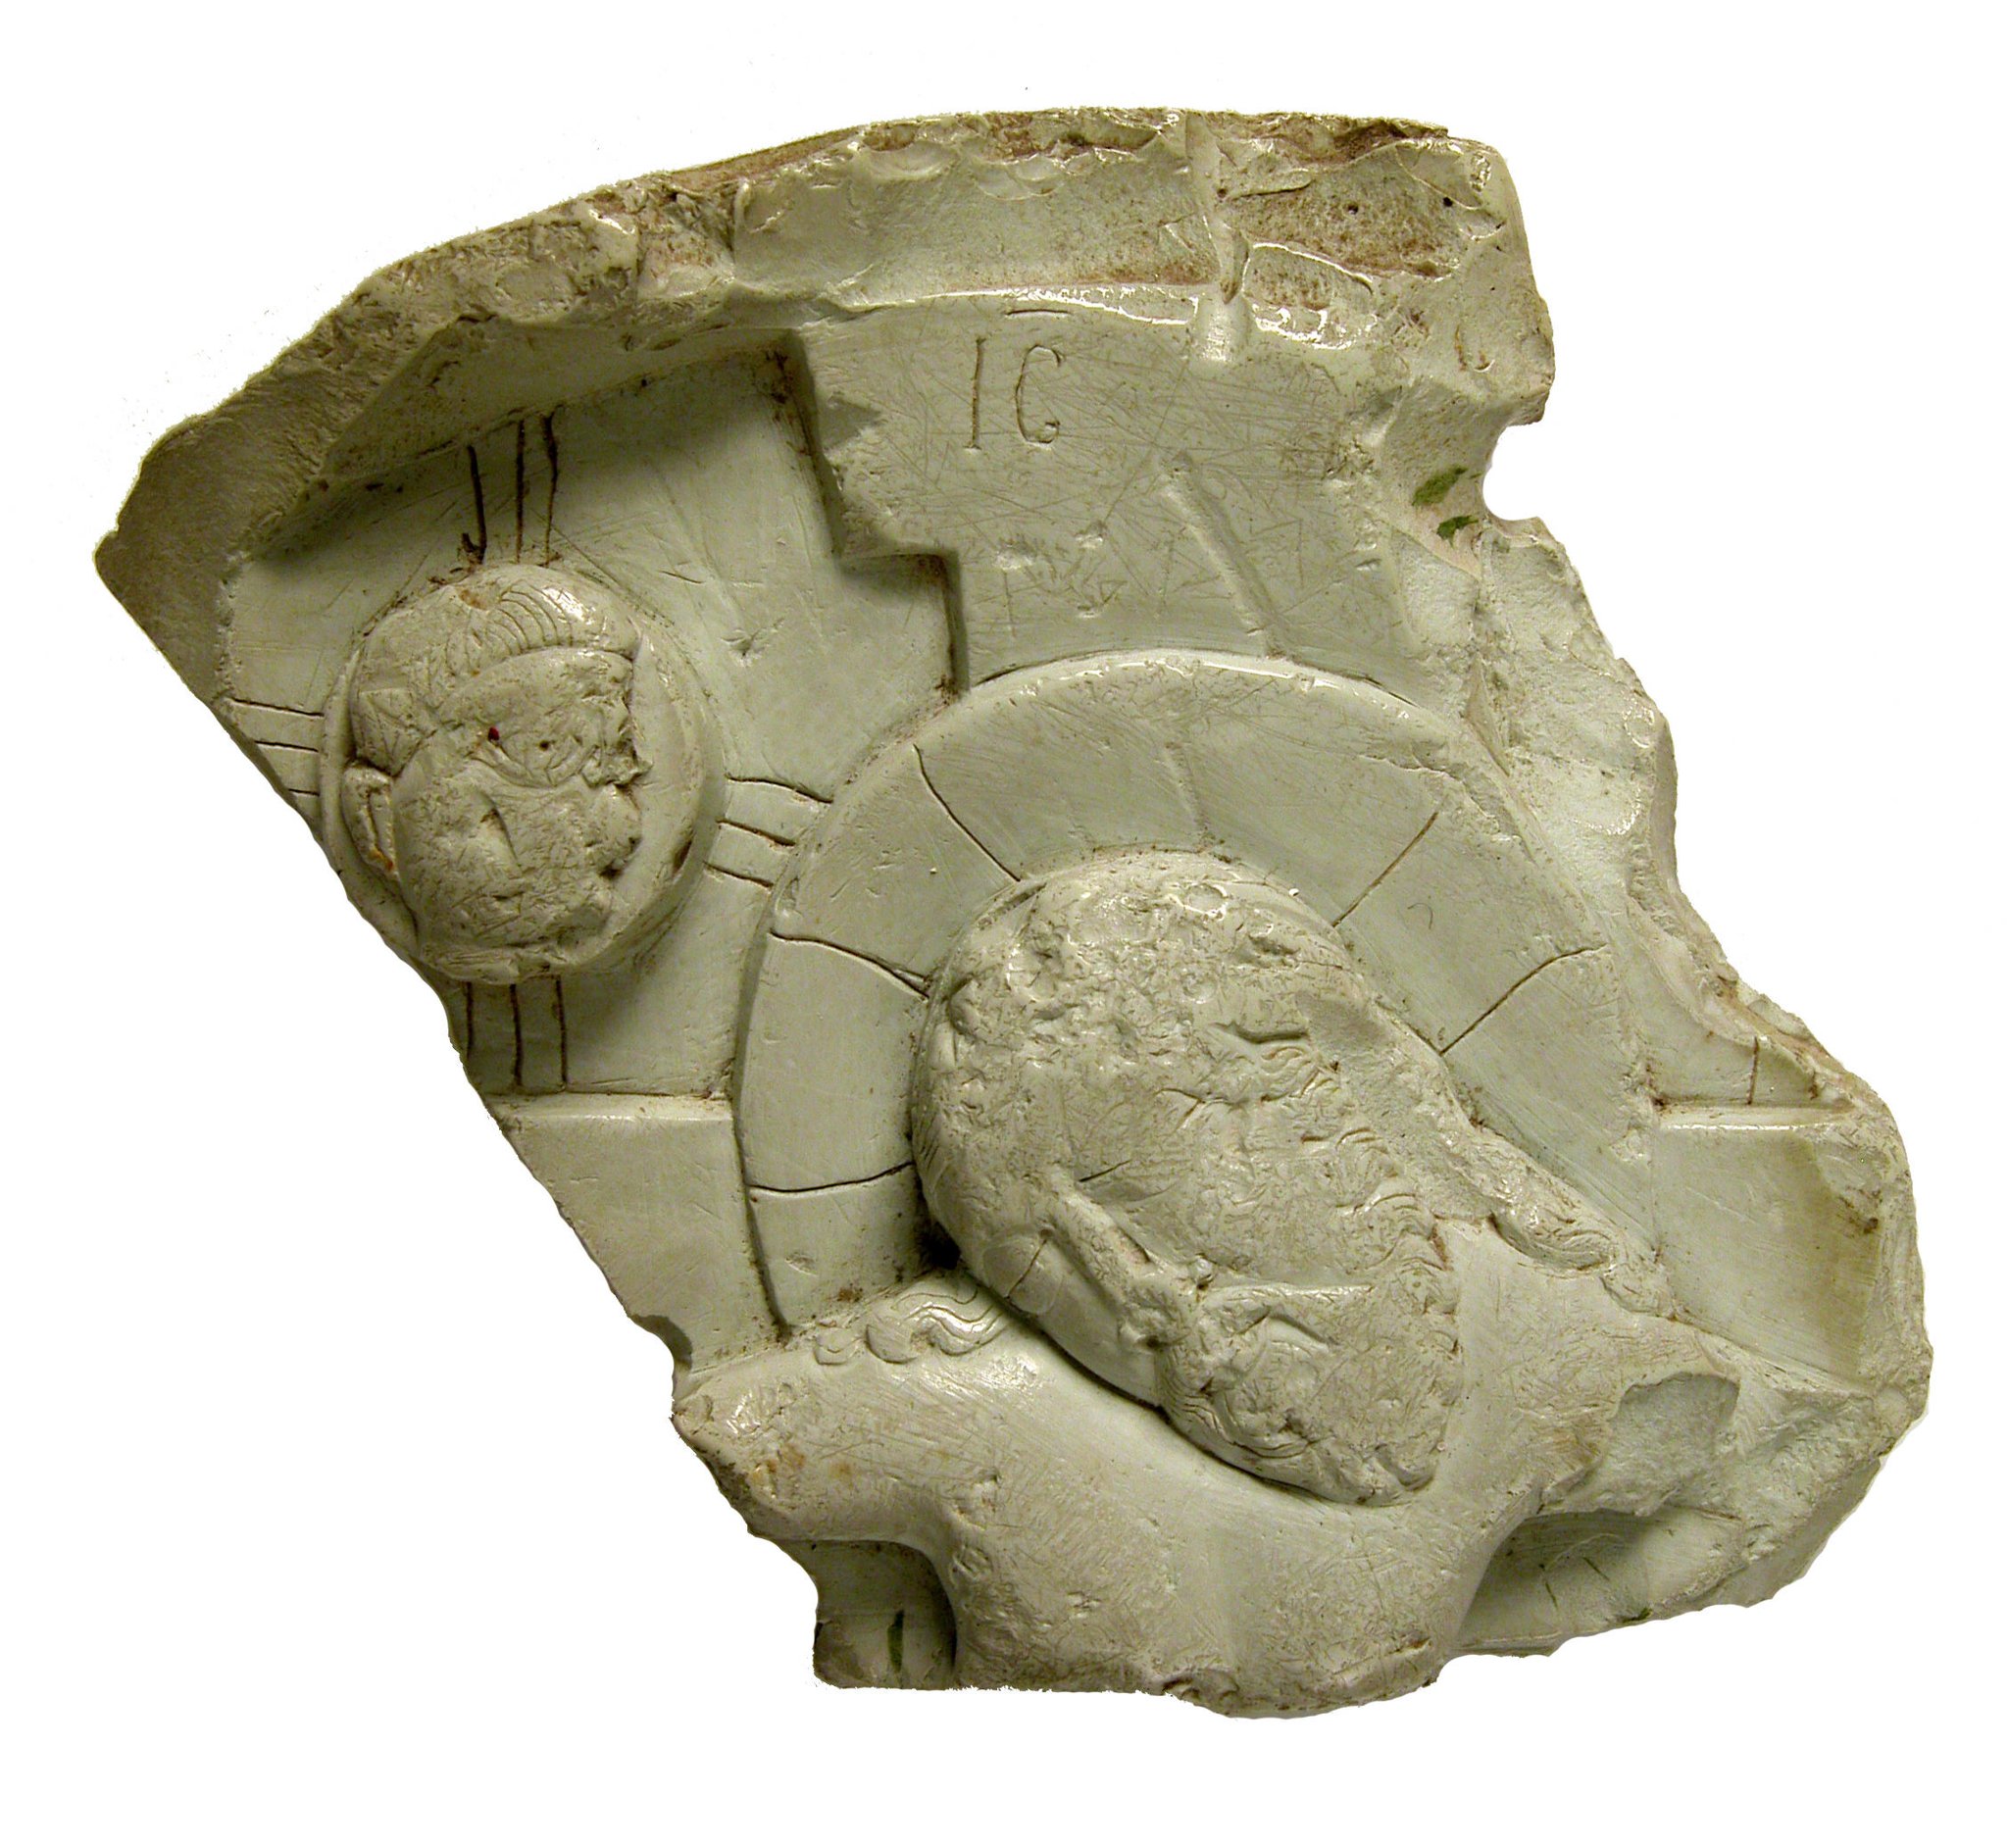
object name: icon fragment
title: Head of Christ, from an Icon of the Crucifixion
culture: byzantine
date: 1101-1200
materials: stone